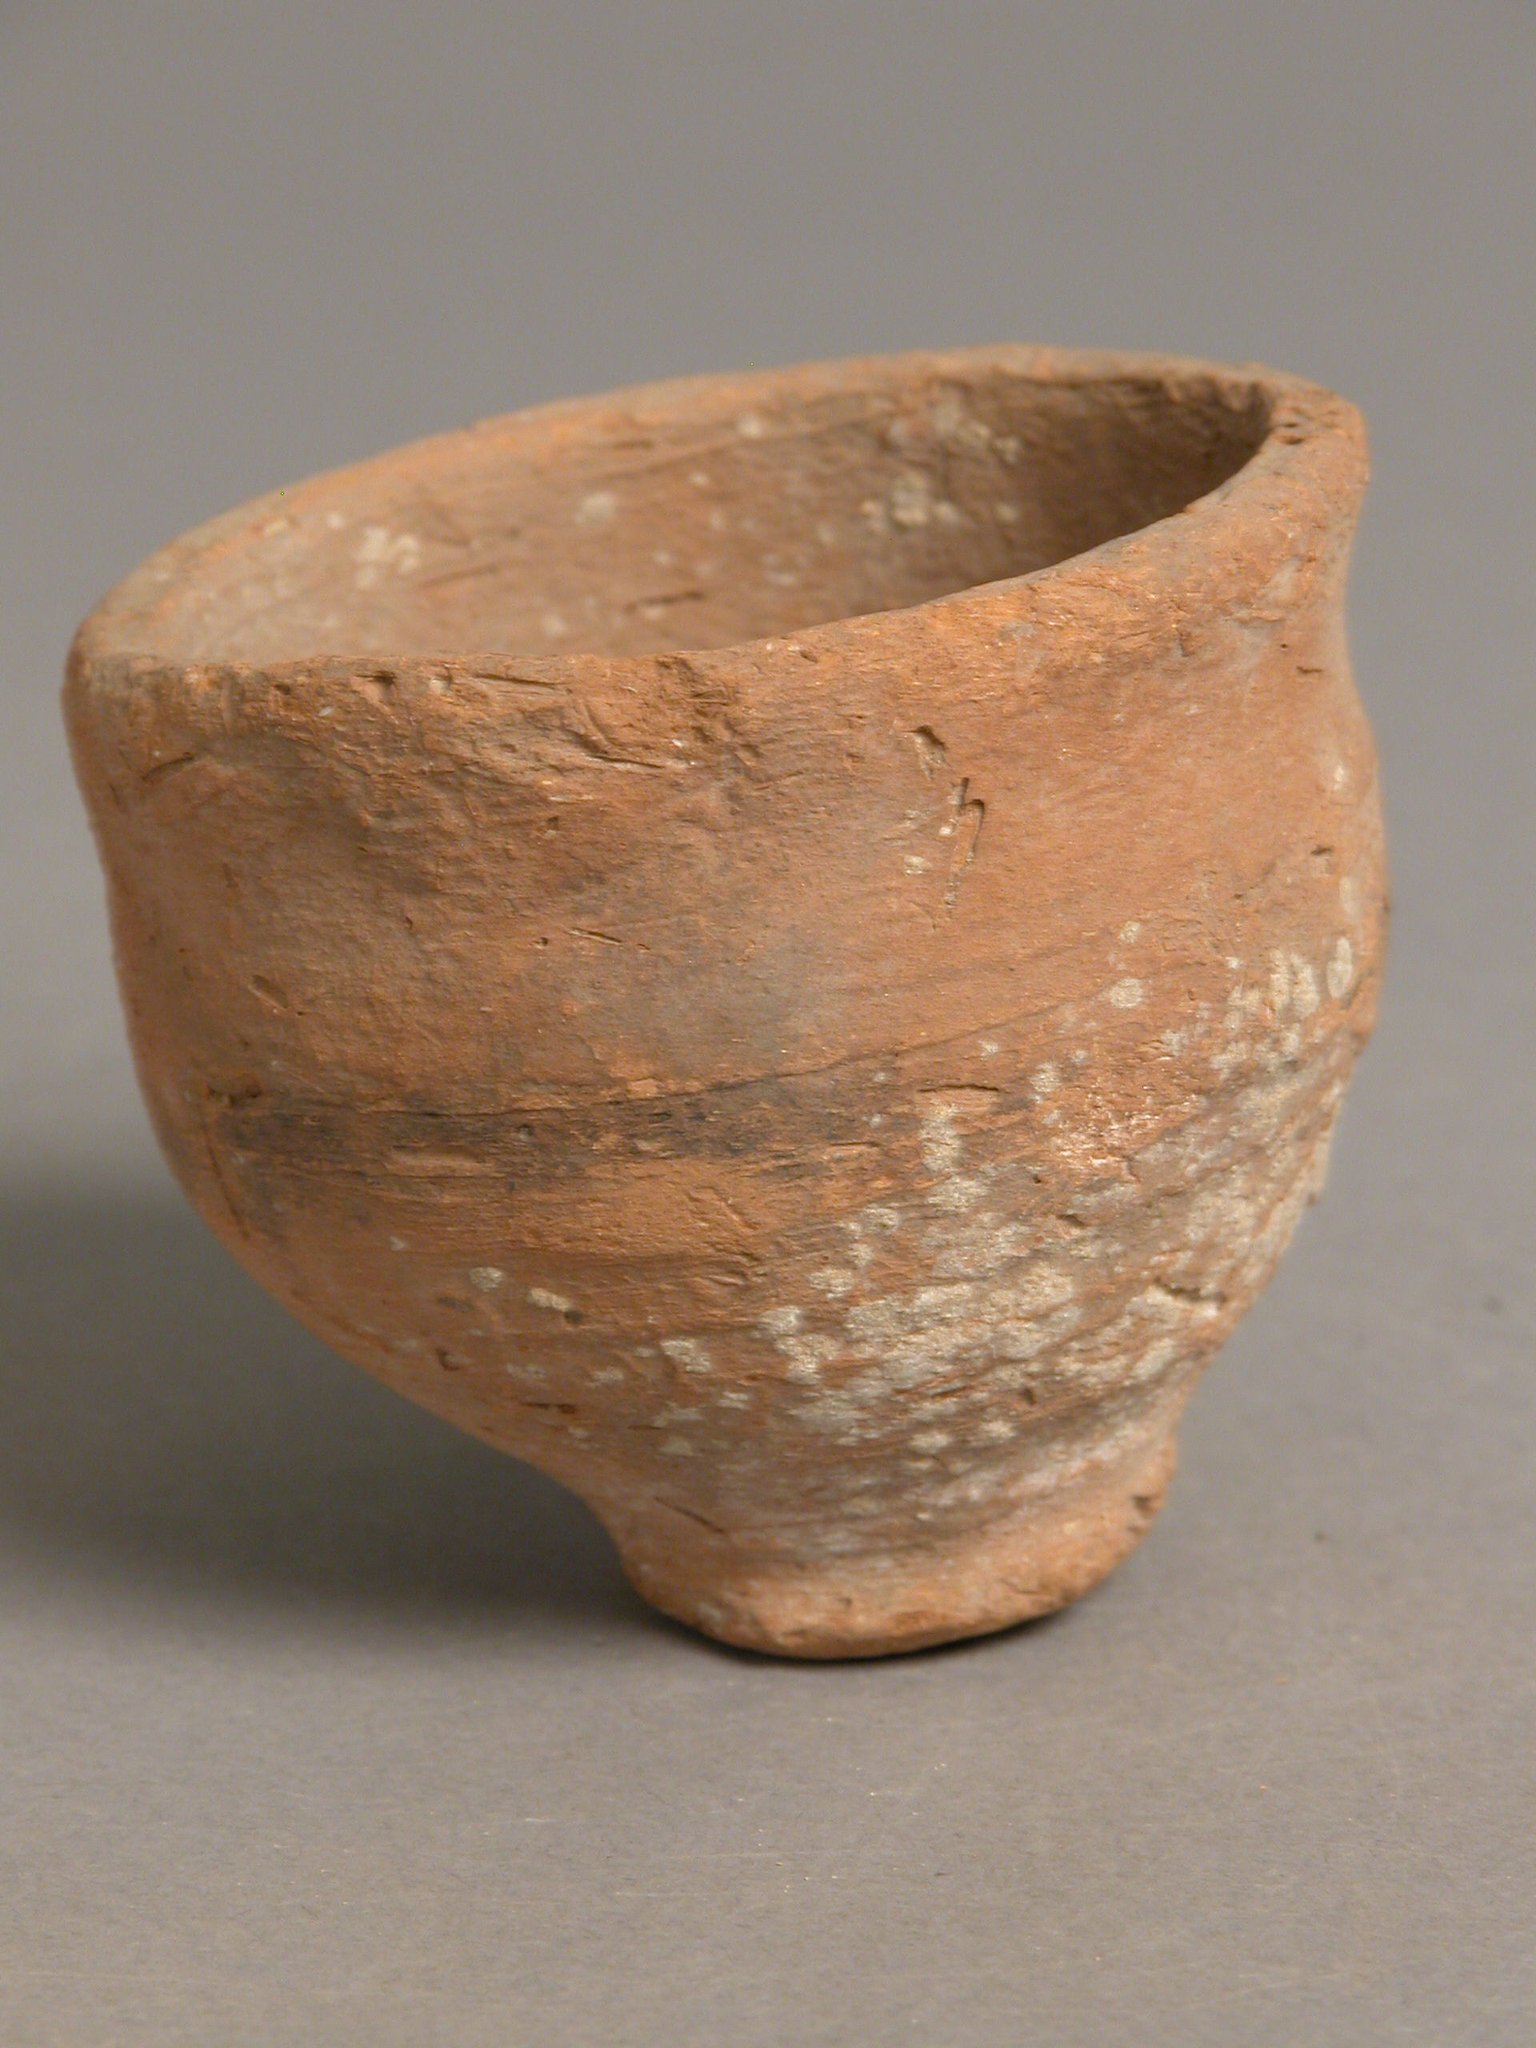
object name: pot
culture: coptic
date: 301-700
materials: earthenware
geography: egypt